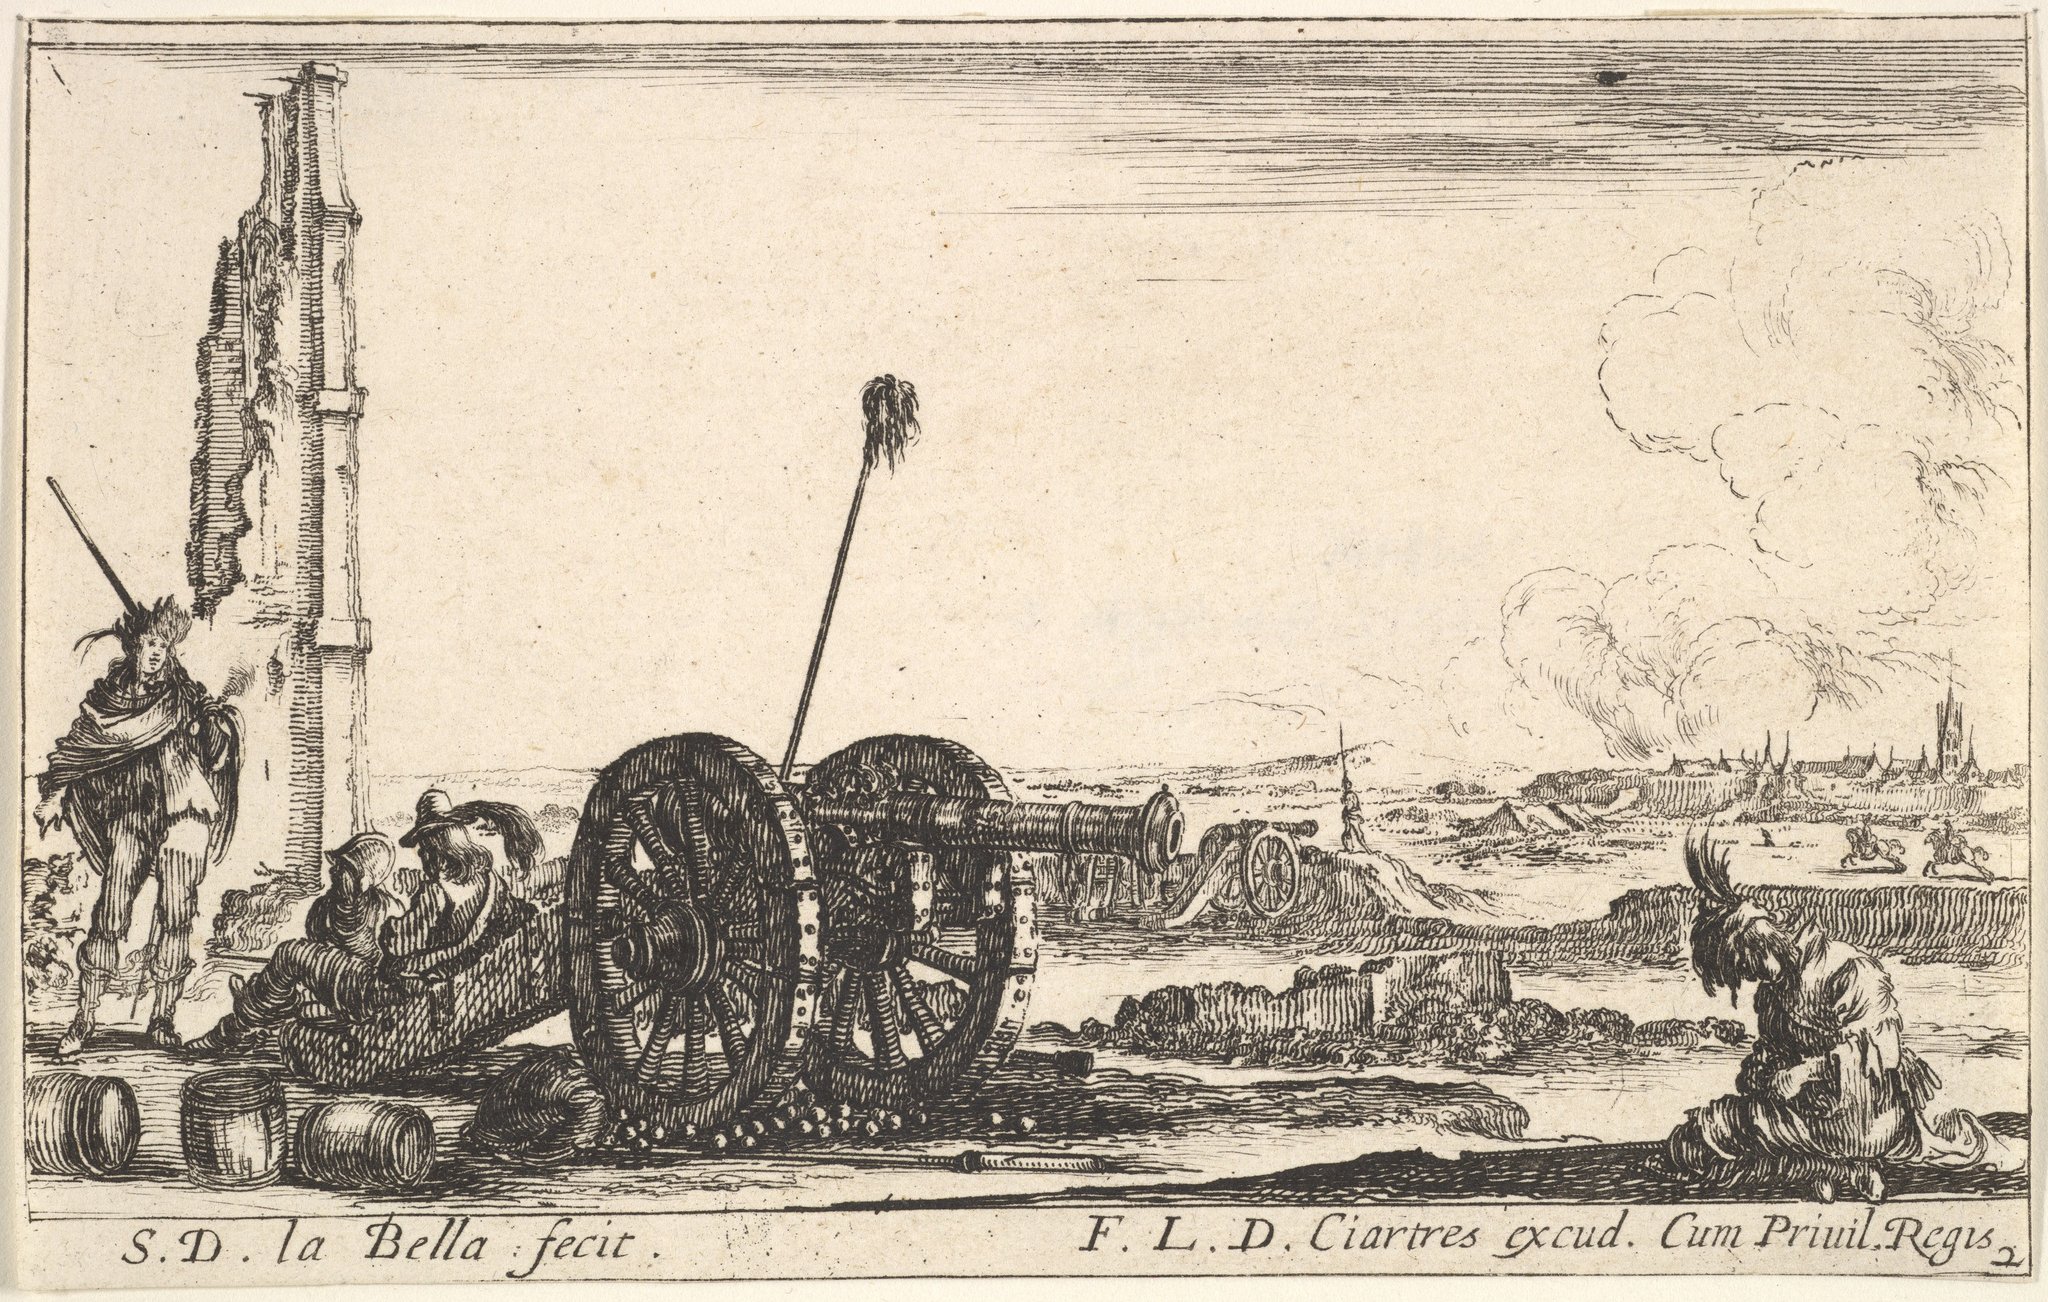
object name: print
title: Plate 2: A cannon to the left, a town in the background, from "Various Military Caprices" (Varii capricci militari)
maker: stefano della bella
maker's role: artist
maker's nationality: italian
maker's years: 1610-1664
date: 1641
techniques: etching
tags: military,cannons